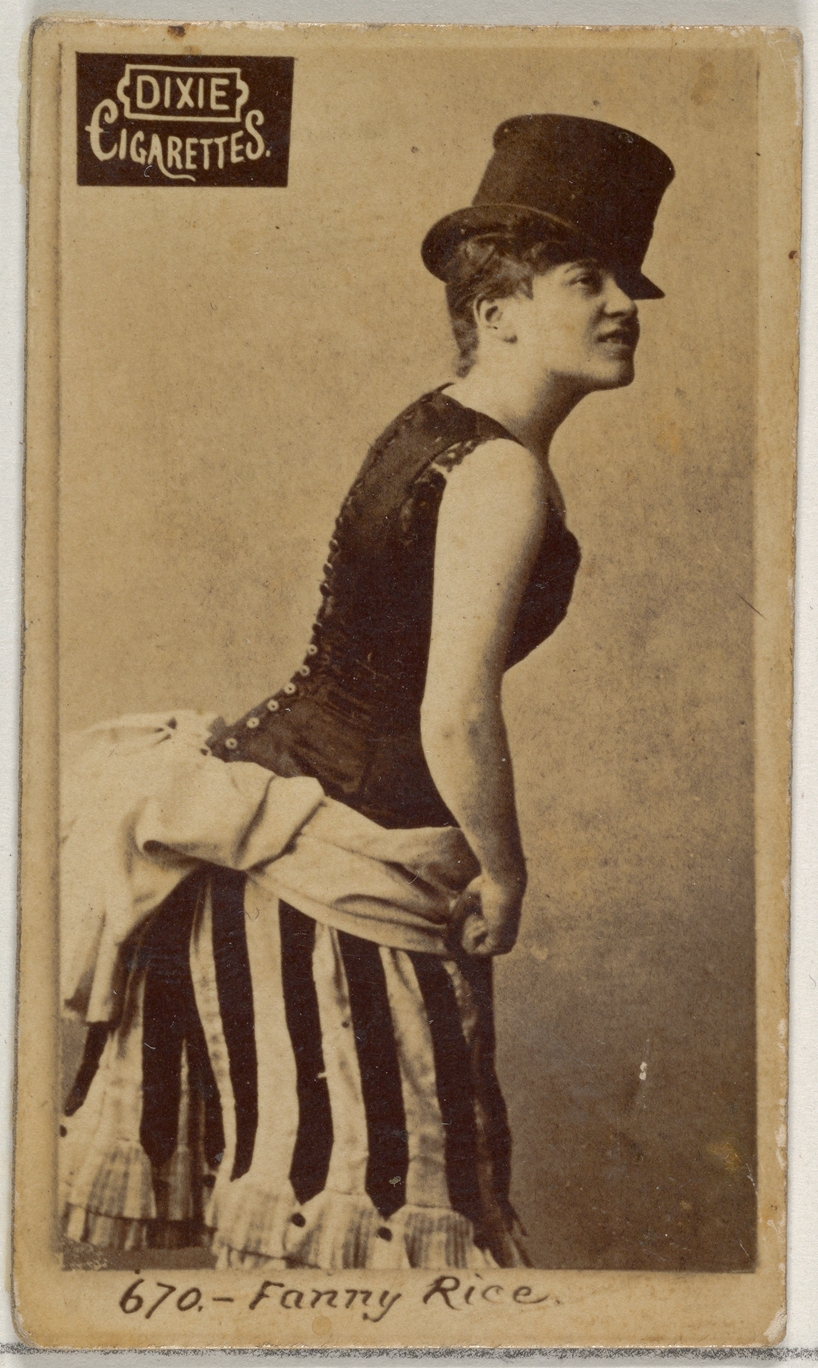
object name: photograph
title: Card 670, Fanny Rice, from the Actors and Actresses series (N45, Type 7) for Dixie Cigarettes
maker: allen & ginter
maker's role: publisher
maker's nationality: american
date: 1888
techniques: albumen silver print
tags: portraits,women,actresses